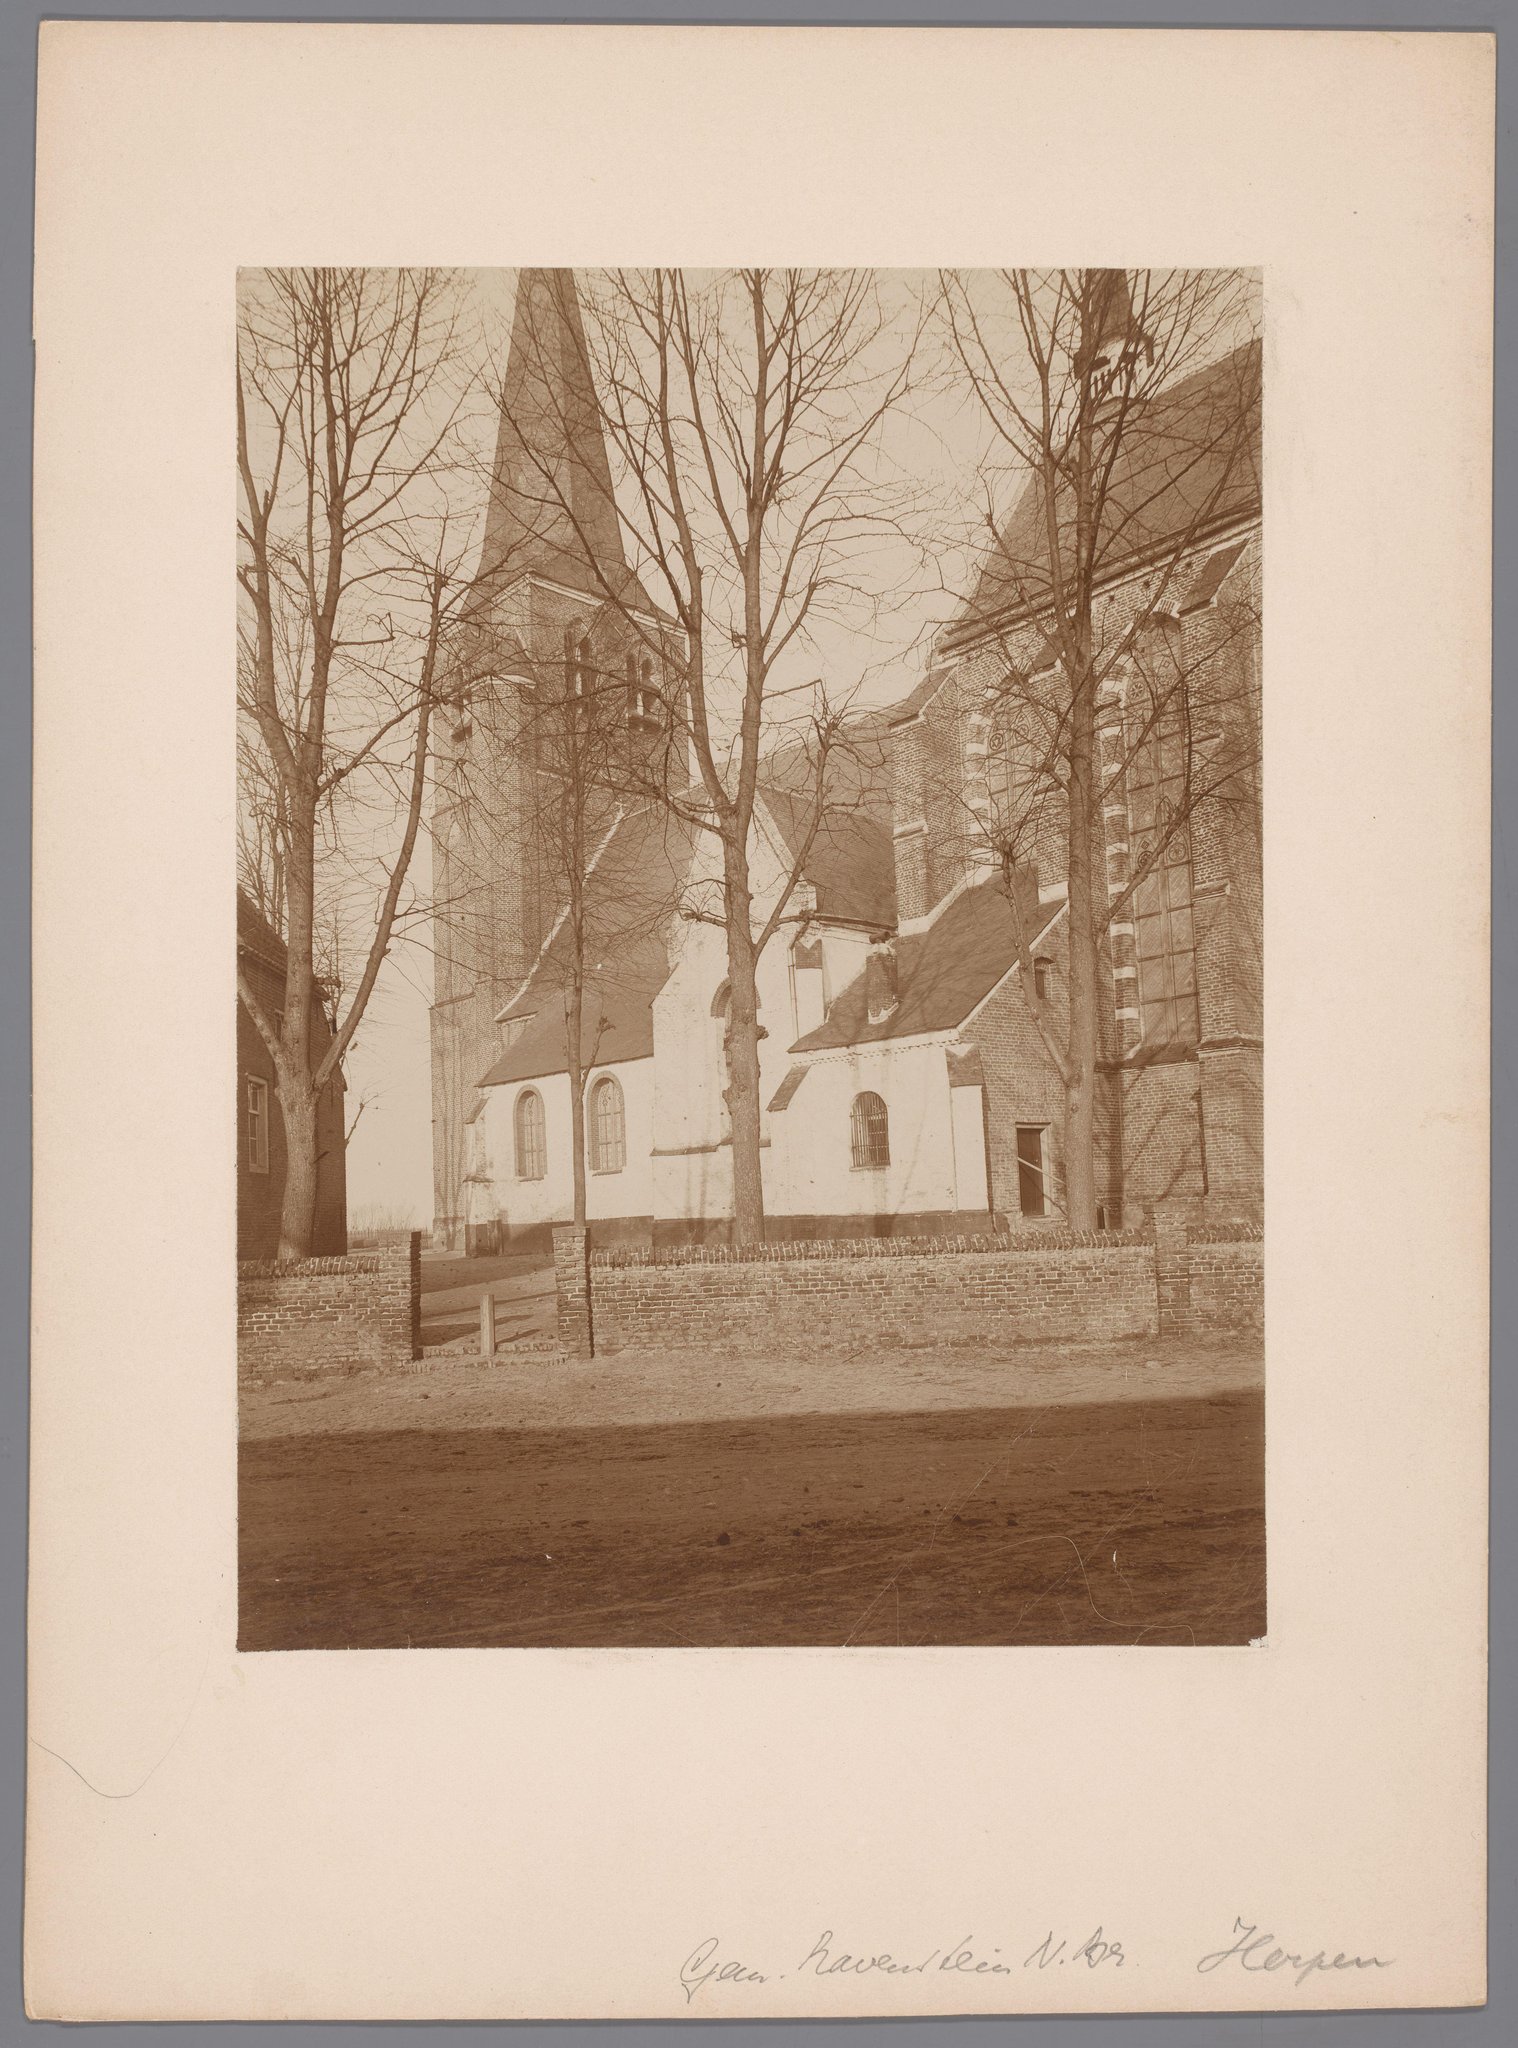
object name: photograph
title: Gezicht op de Sint-Sebastianuskerk te Herpen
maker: anoniem (monumentenzorg)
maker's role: fotograaf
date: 1890-1907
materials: cardboard, photographic support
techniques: collodion silver print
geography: herpen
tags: church (exterior)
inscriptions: annotation: ‘Gem. Ravenstein N.Br./ Herpen’, annotation: ‘R.K. Kerk te Herpen (N.B.)/ topografie N.Br. H.’